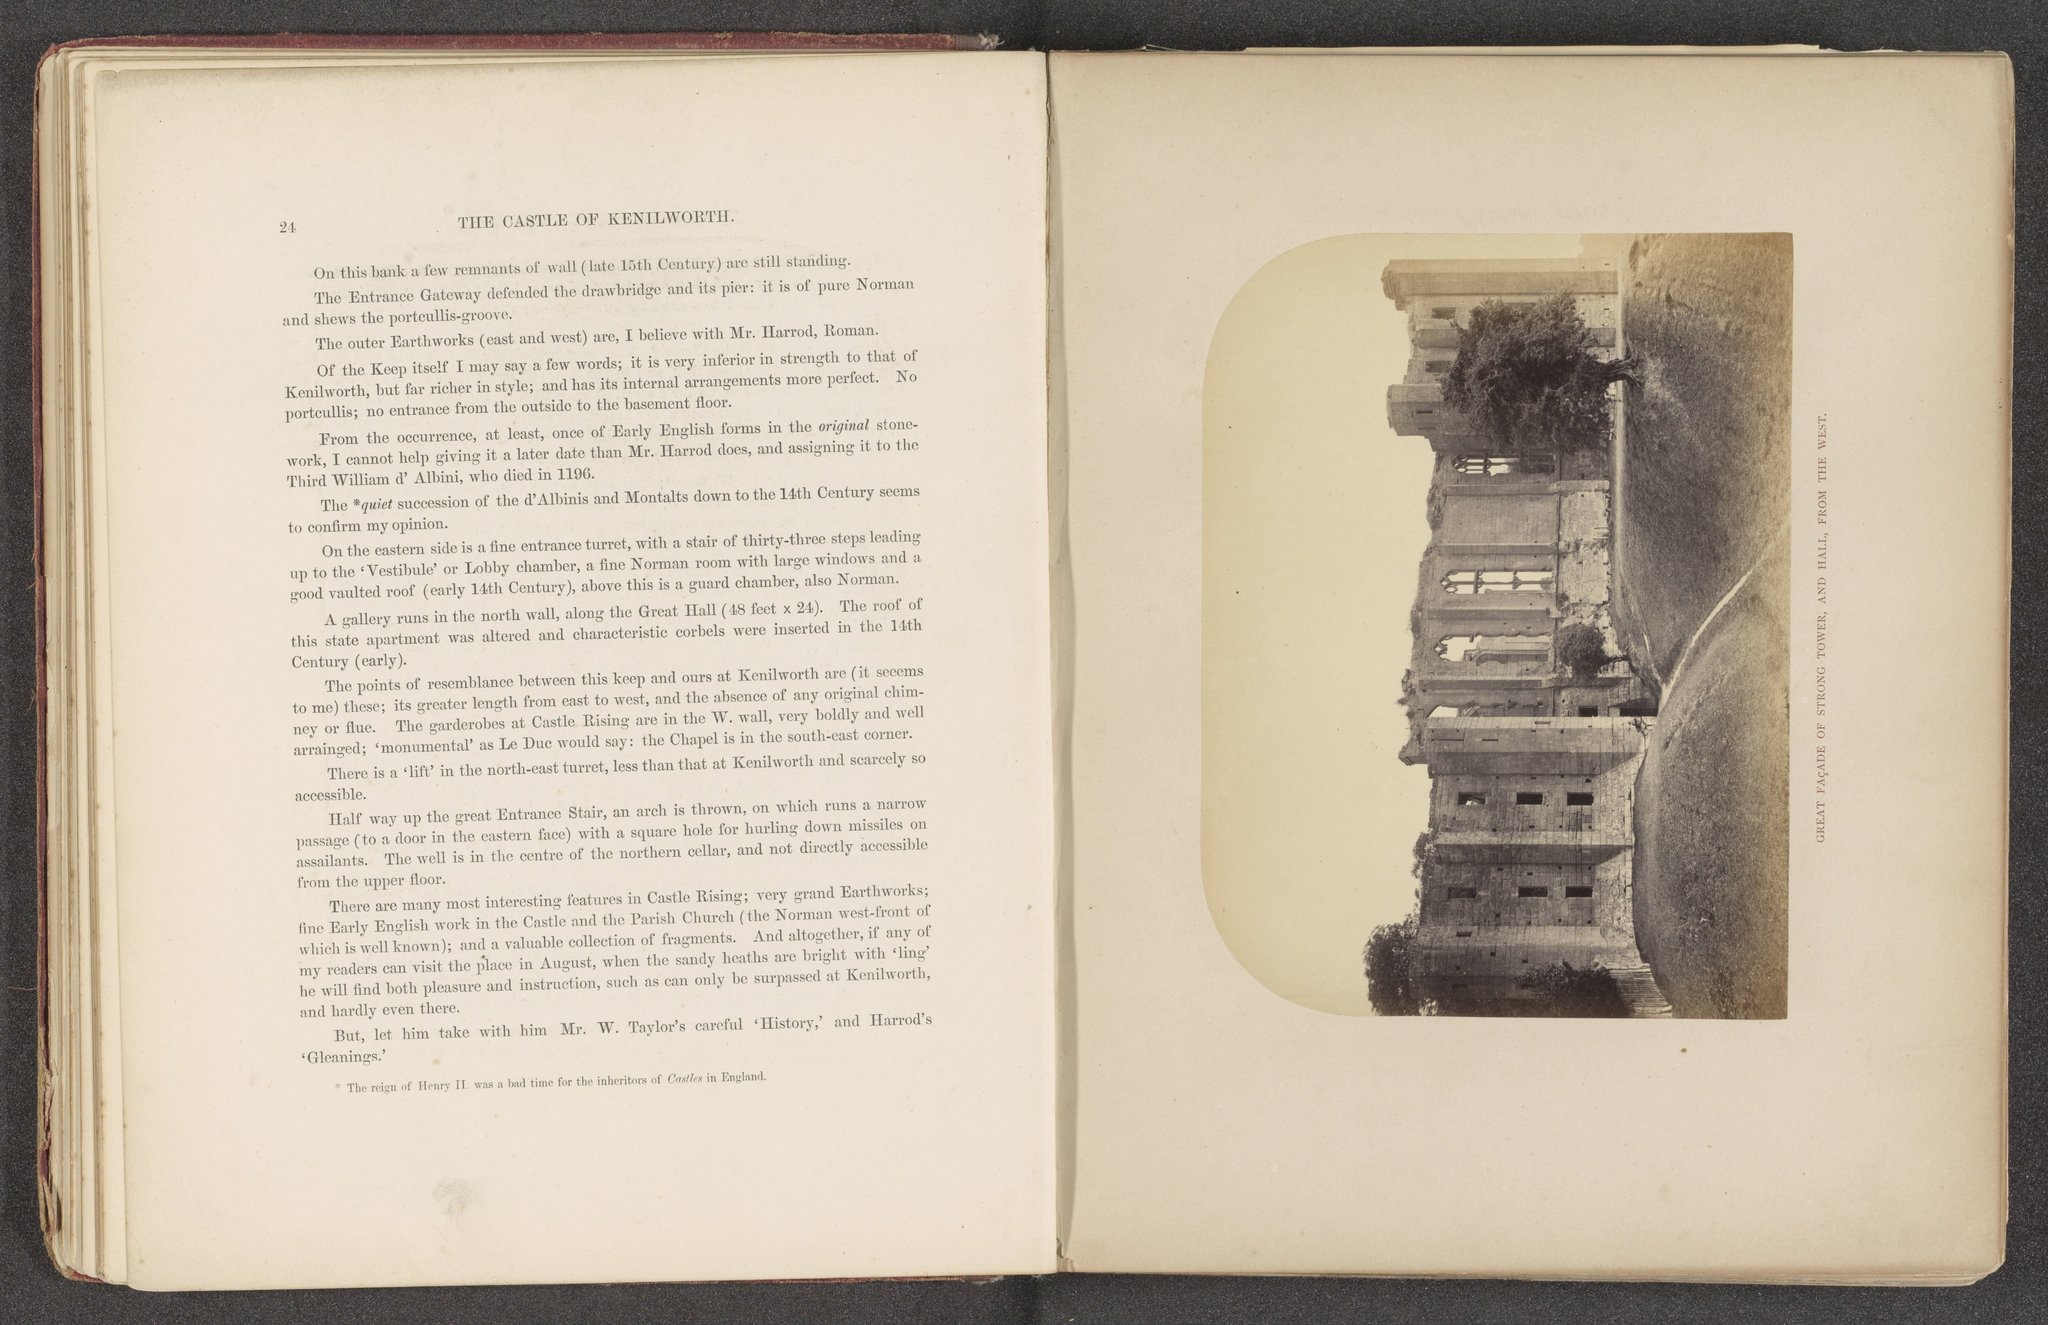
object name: photograph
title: Gezicht op de ruïne van de façade van het Kasteel van Kenilworth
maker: Anonymous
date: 1862-1872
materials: photographic support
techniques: albumen print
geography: kenilworth castle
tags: tower, clock tower ~ monumental adornment, façade (of house or building), ruin of a dwelling, house, castle, etc.